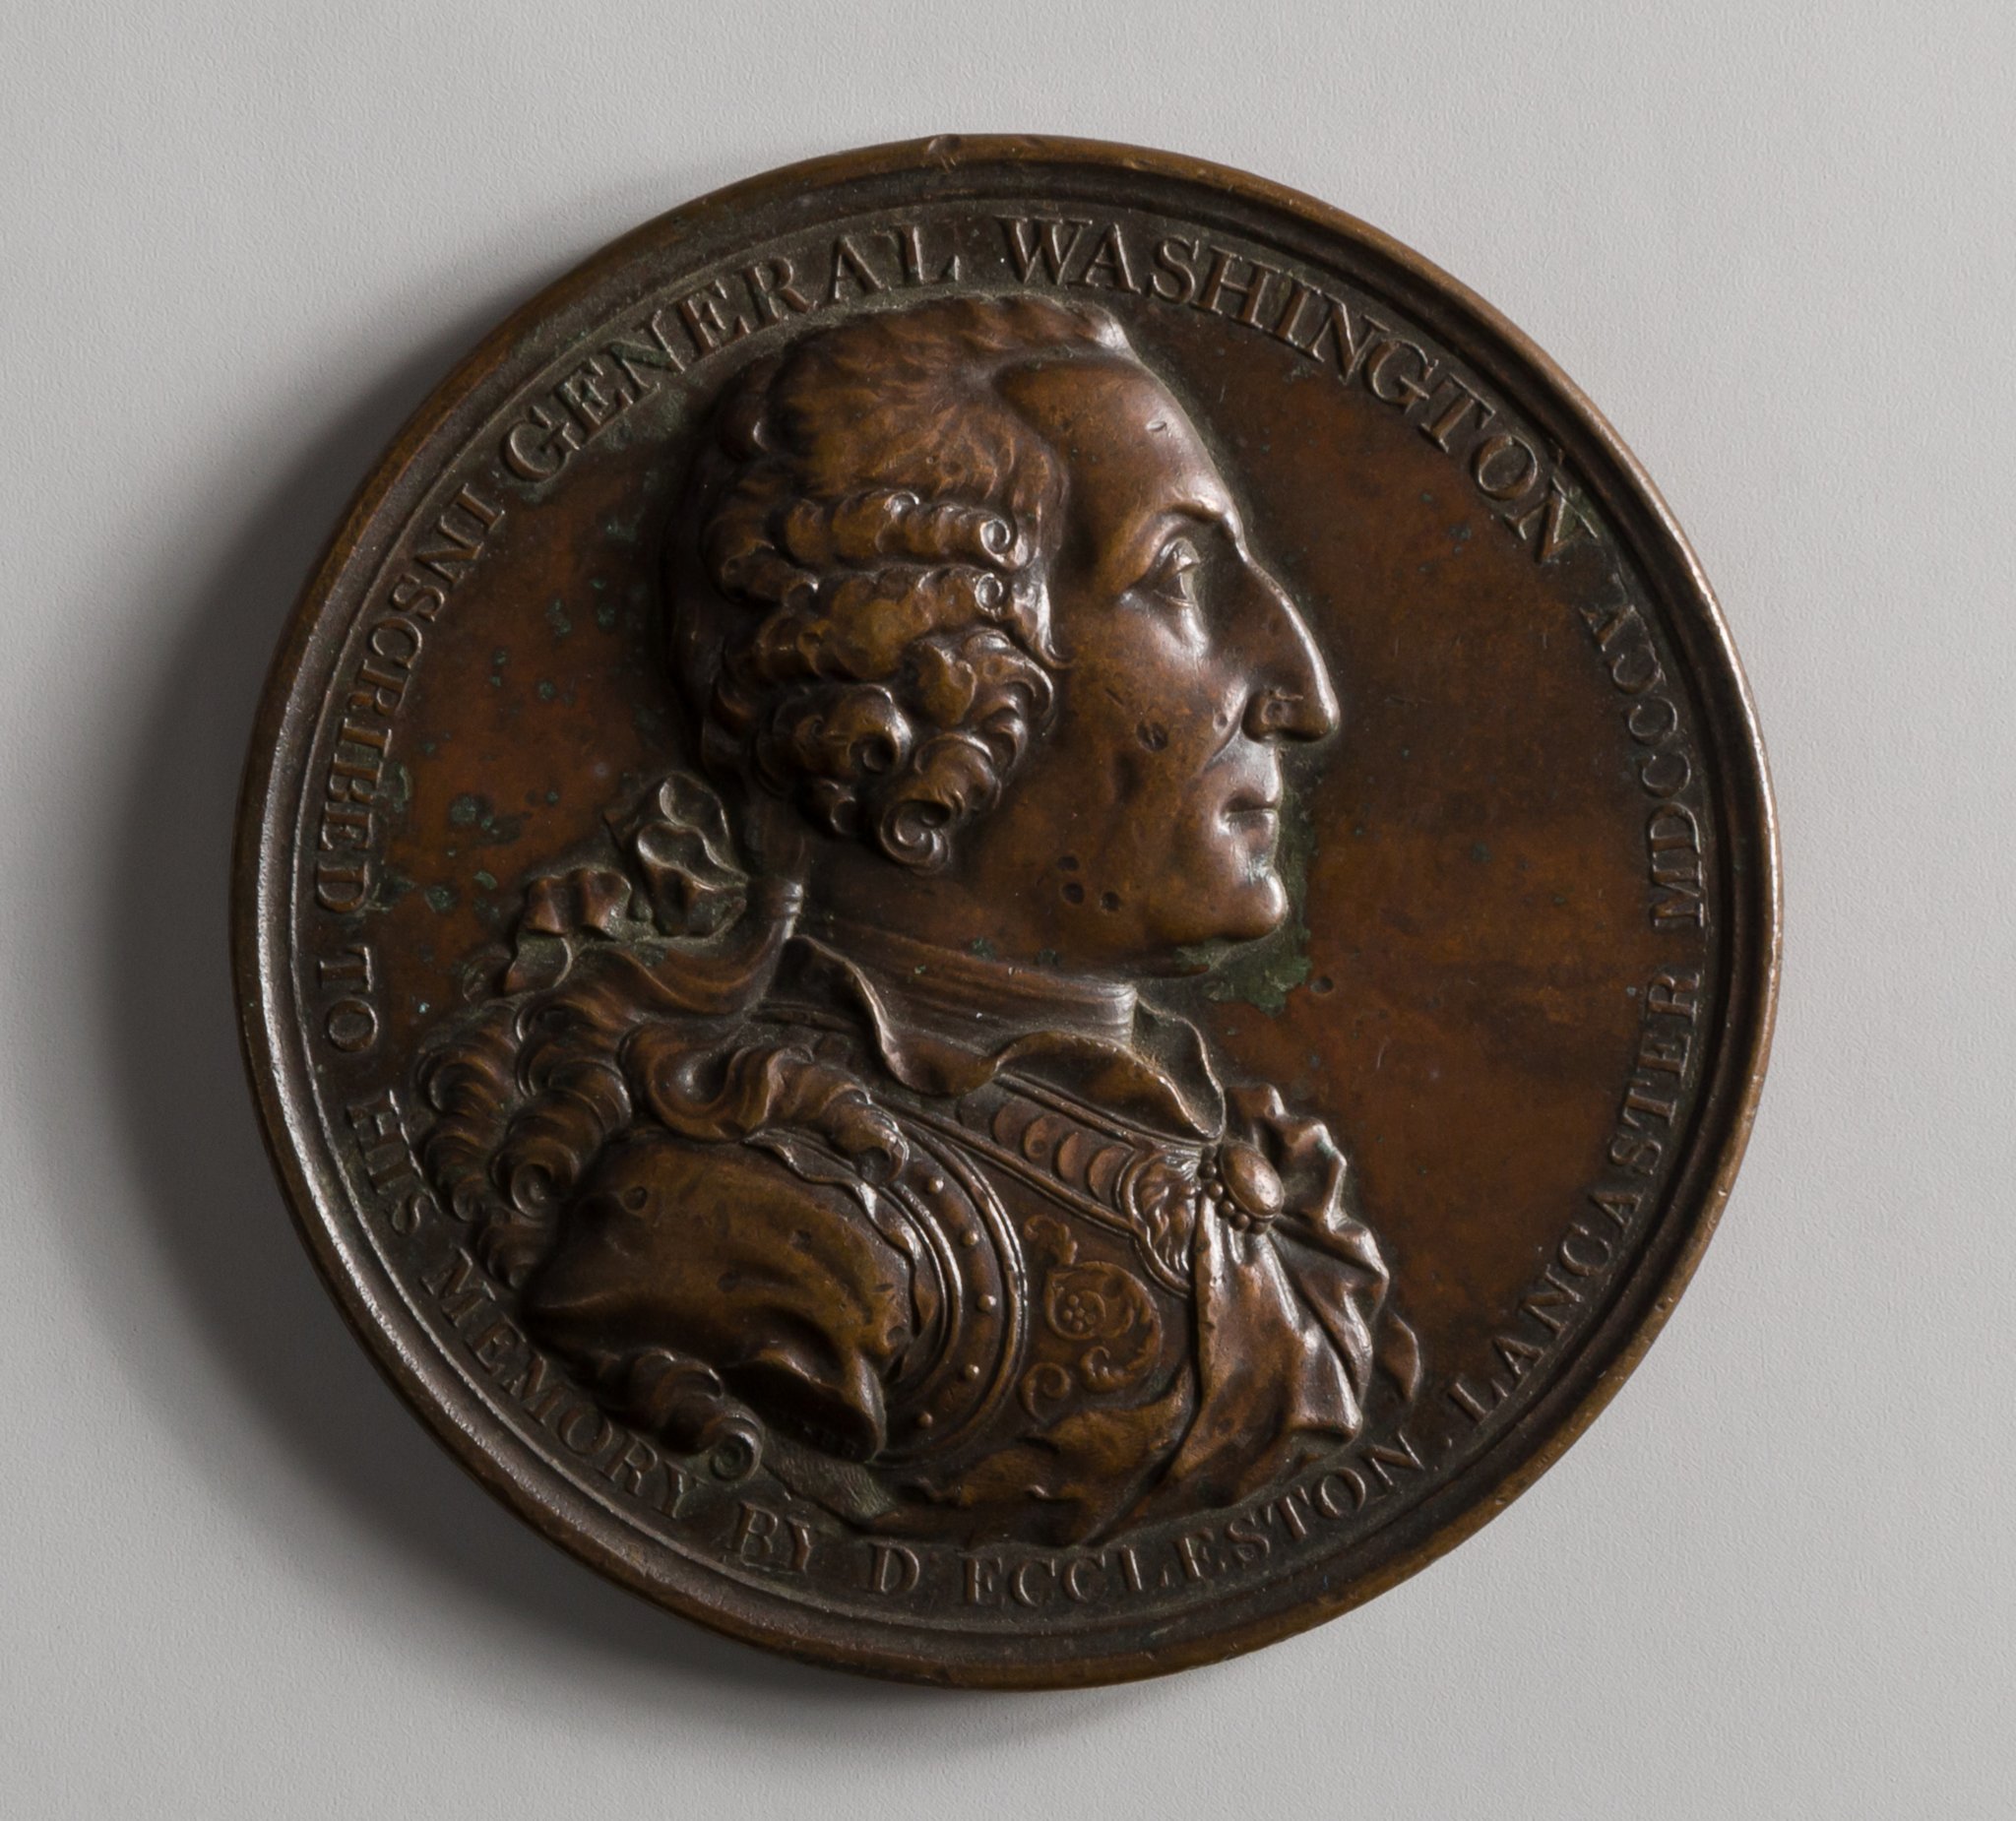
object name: medal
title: Eccleston Medal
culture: american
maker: thomas webb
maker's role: artist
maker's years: 1804-1827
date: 1805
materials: bronze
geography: united kingdom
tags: george washington,men,profiles